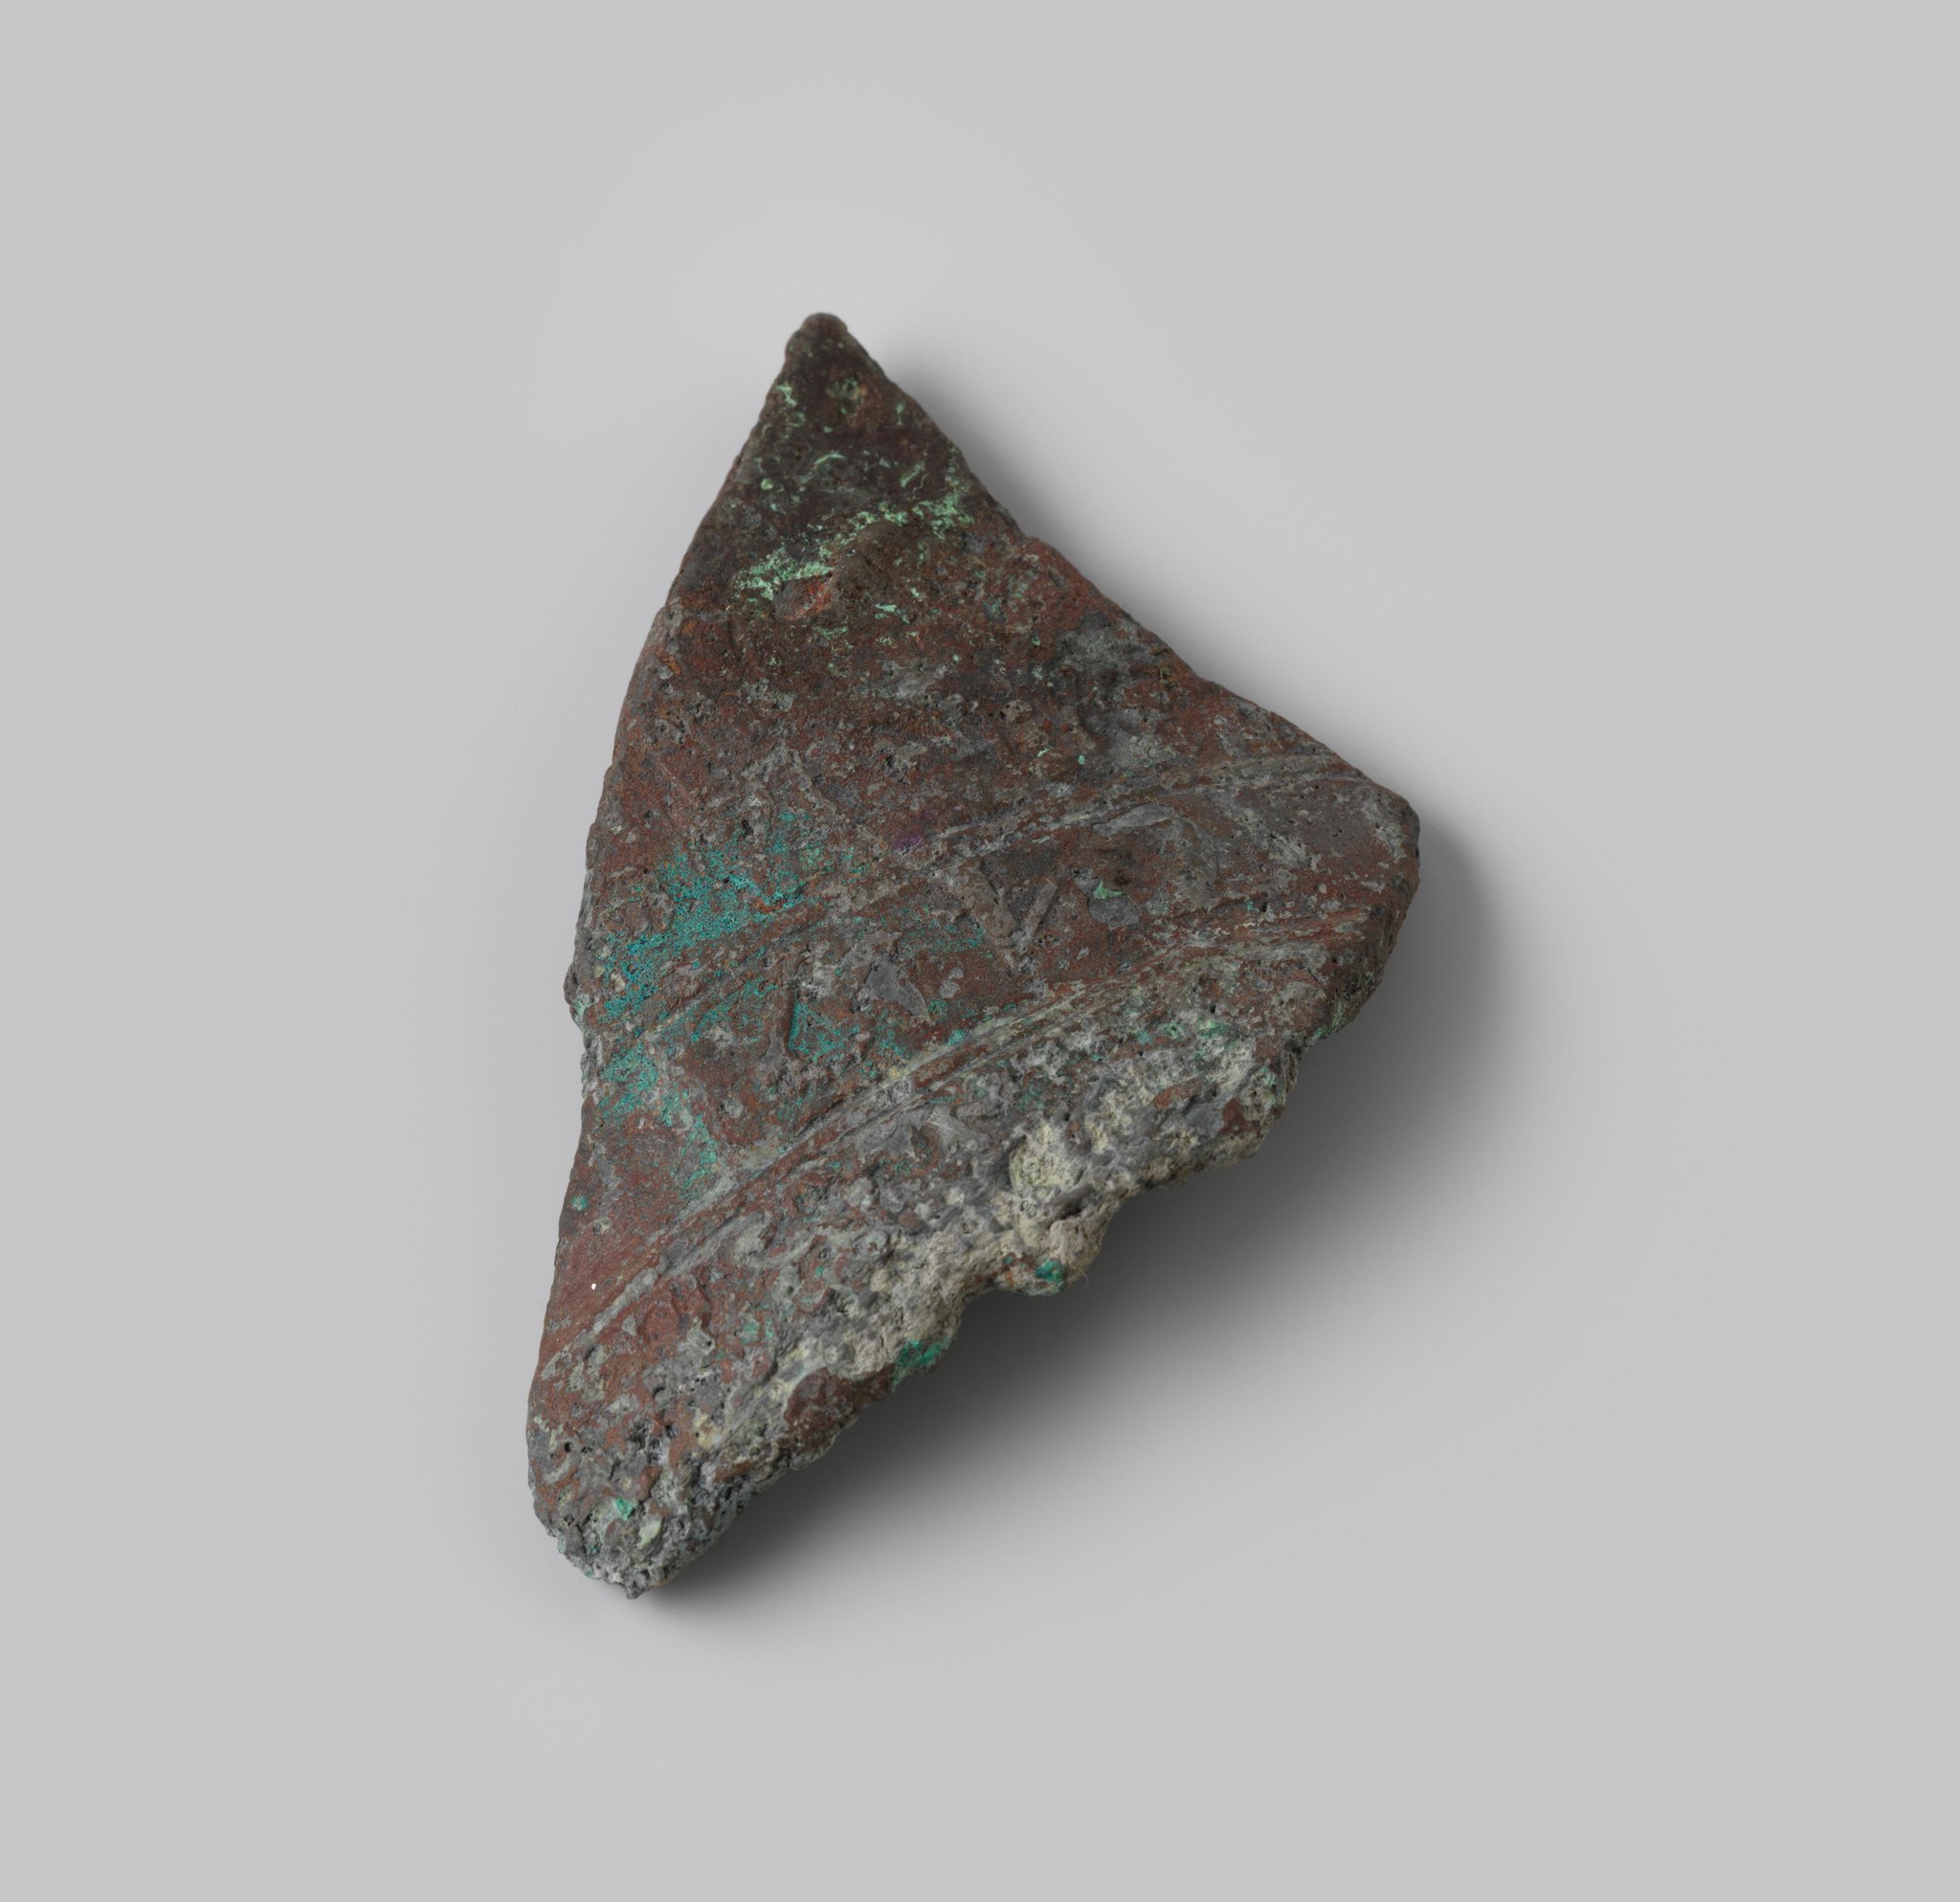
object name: ship bell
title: Dated (1742) fragment of a ship's bell from the wreck of the Dutch East Indiaman Hollandia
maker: Anonymous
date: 1700-1743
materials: copper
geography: netherlands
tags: verenigde oostindische compagnie, hollandia (schip), annet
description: Acoustic, bell (ship's); fragment of body, eroded, fragm of inscription [1742], fits to NG 1980-27H3010a.